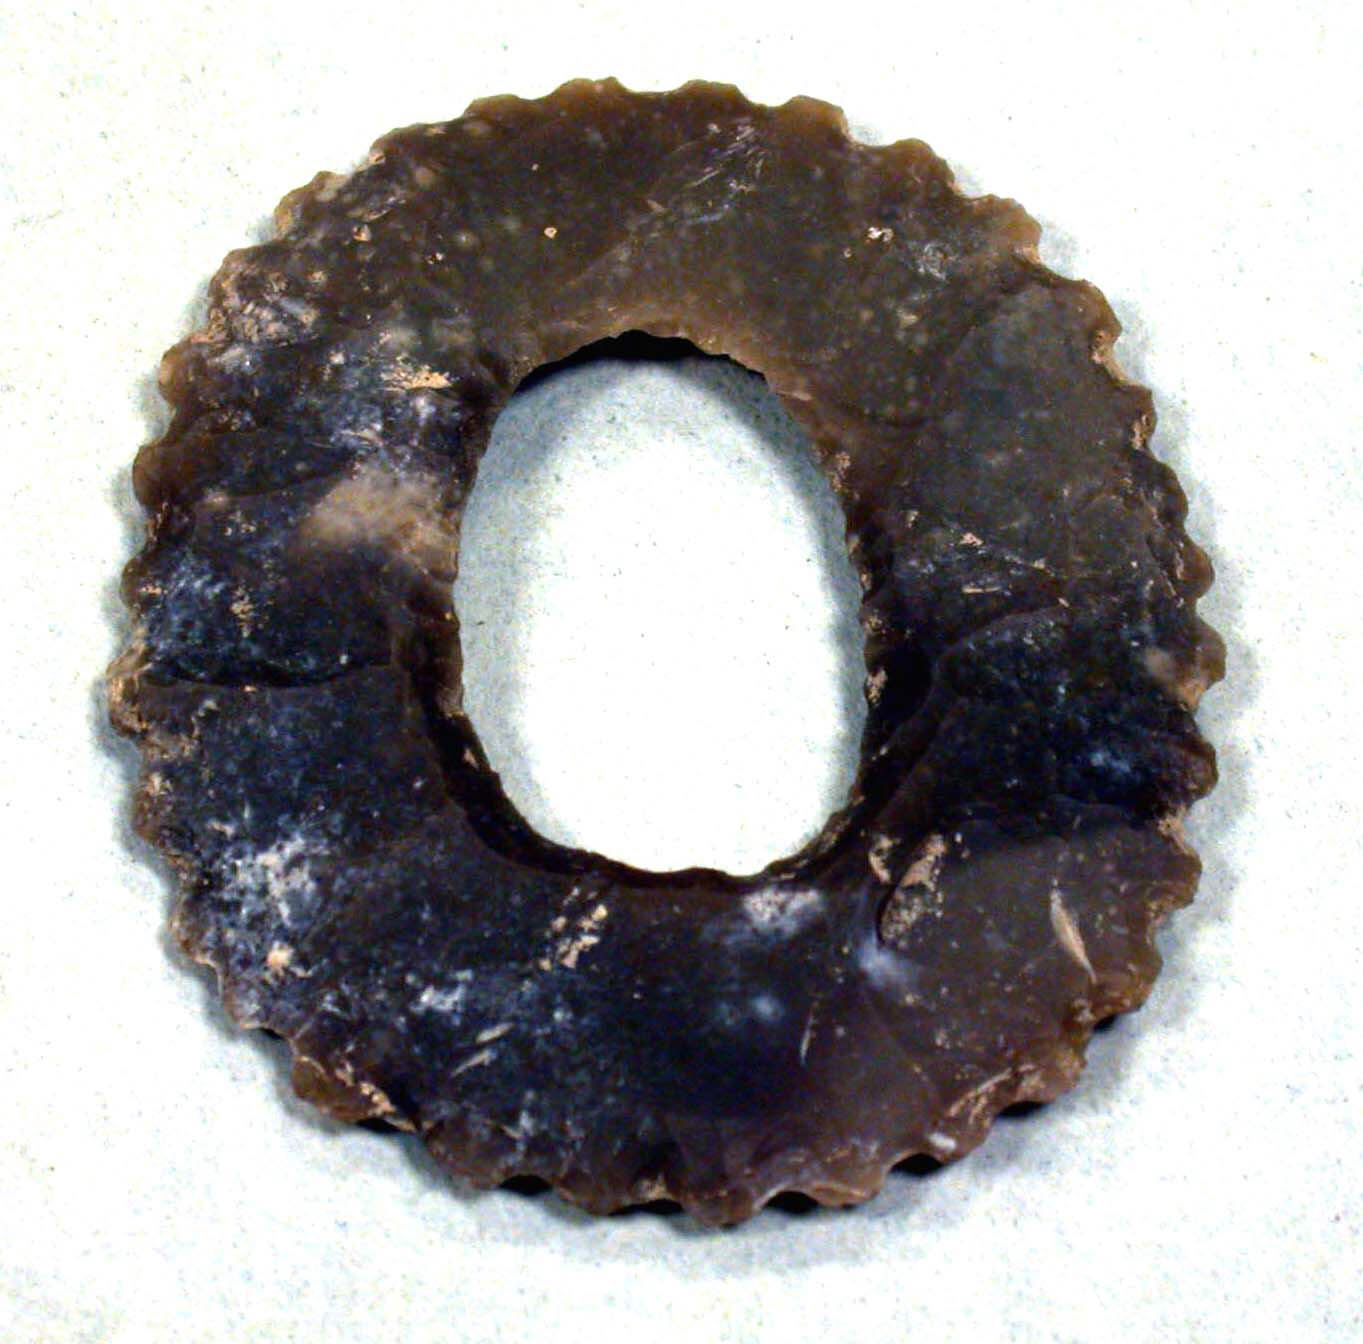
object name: knife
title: Eccentric Blade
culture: mexican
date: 1501-1600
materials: obsidian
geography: mexico